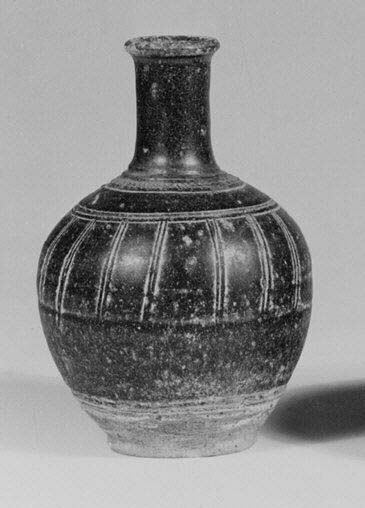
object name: bottle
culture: thailand, buriram province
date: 1101-1133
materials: stoneware